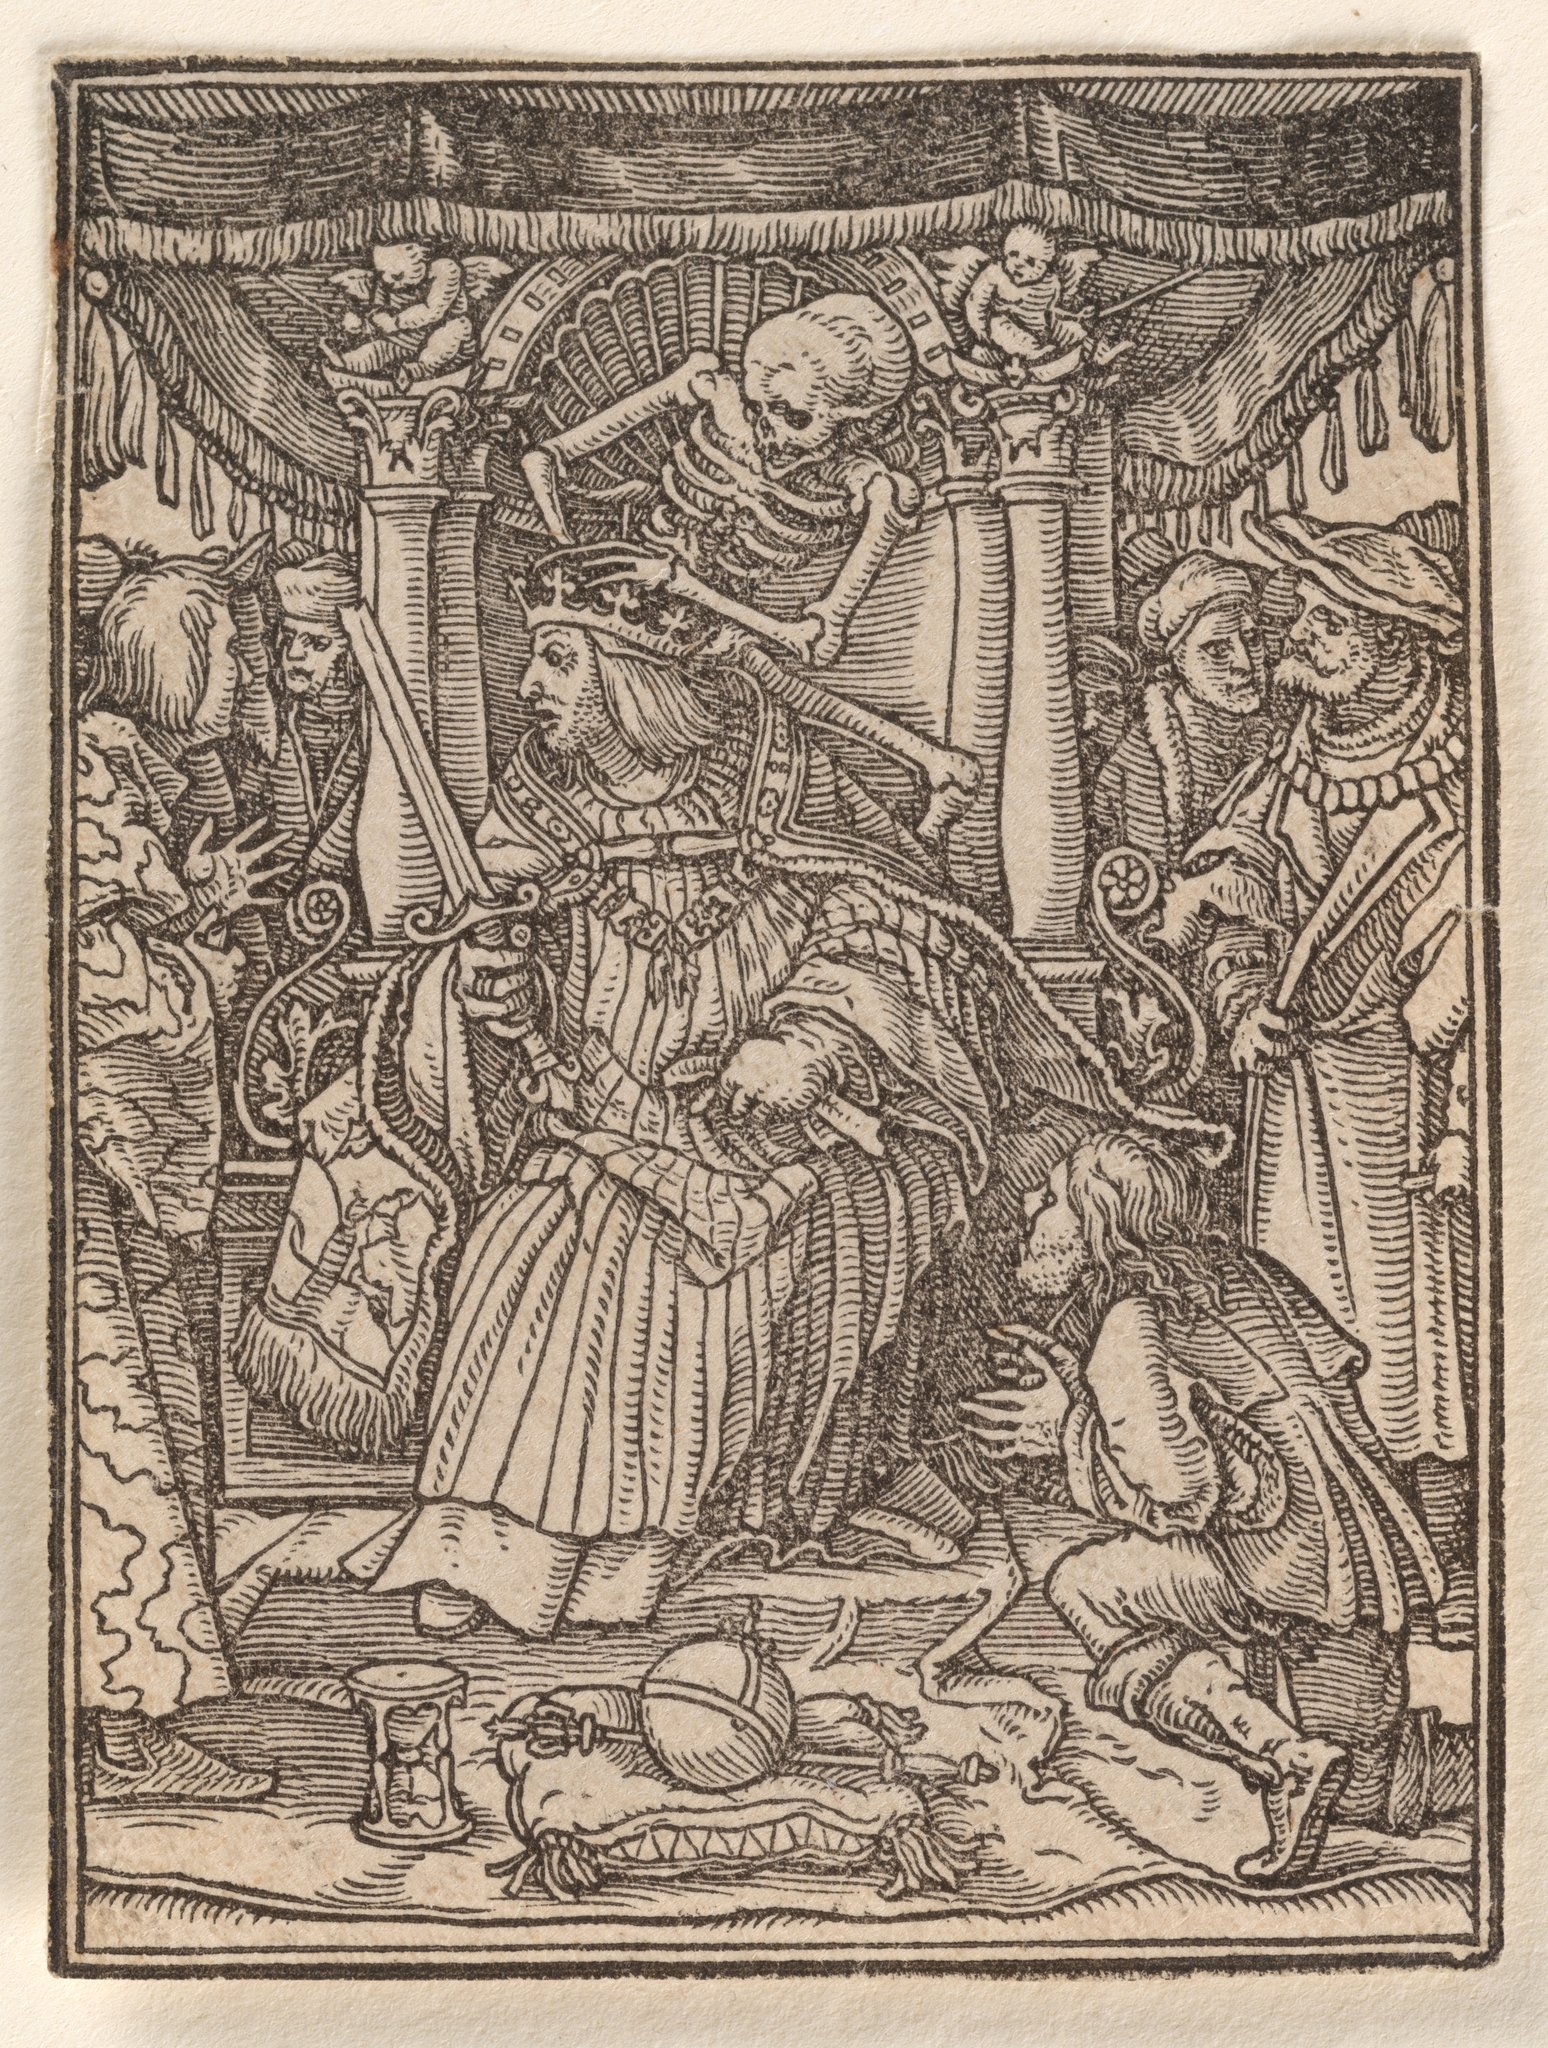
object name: print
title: The Emperor, from "The Dance of Death"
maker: hans holbein the younger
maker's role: artist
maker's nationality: german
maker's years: 1497-1543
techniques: woodcut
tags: emperors,skeletons